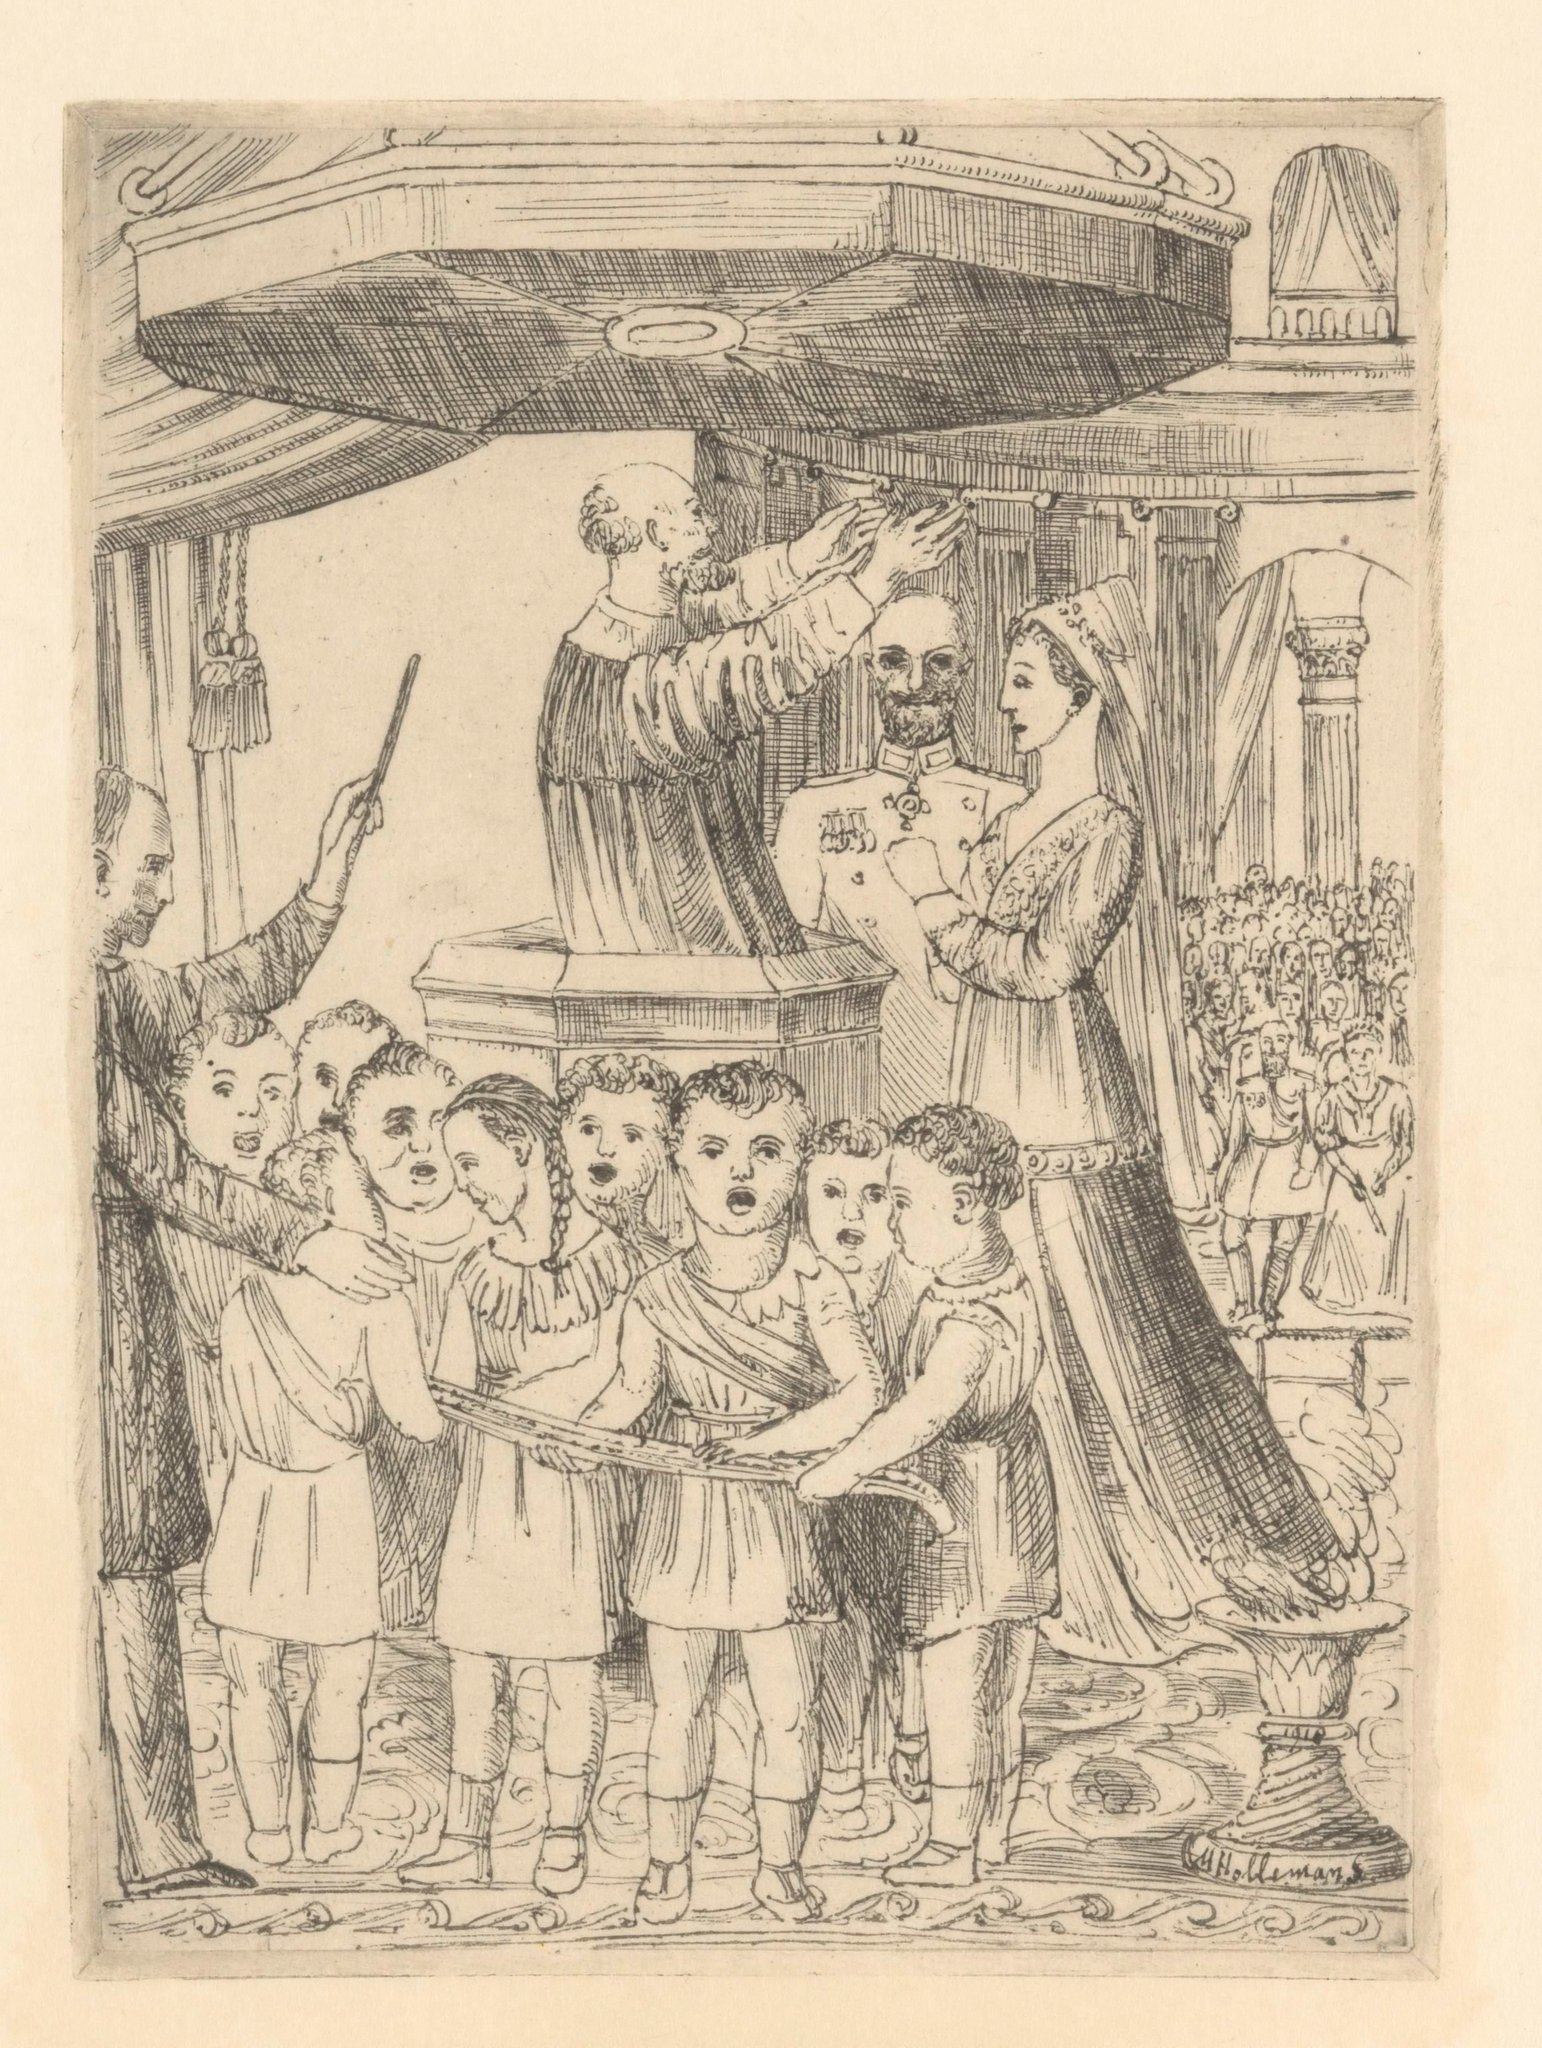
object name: print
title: Huwelijksinzegening van een officier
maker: marius holleman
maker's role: draughtsman, print maker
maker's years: 1878-1926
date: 1918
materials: paper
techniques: etching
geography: groningen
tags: choir (in church), bride and groom in wedding-dress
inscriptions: collector's mark: Lugt 2228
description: Rechts het bruidspaar bij het spreekgestoelte. Op de voorgrond een kinderkoor; op de achtergrond het publiek.